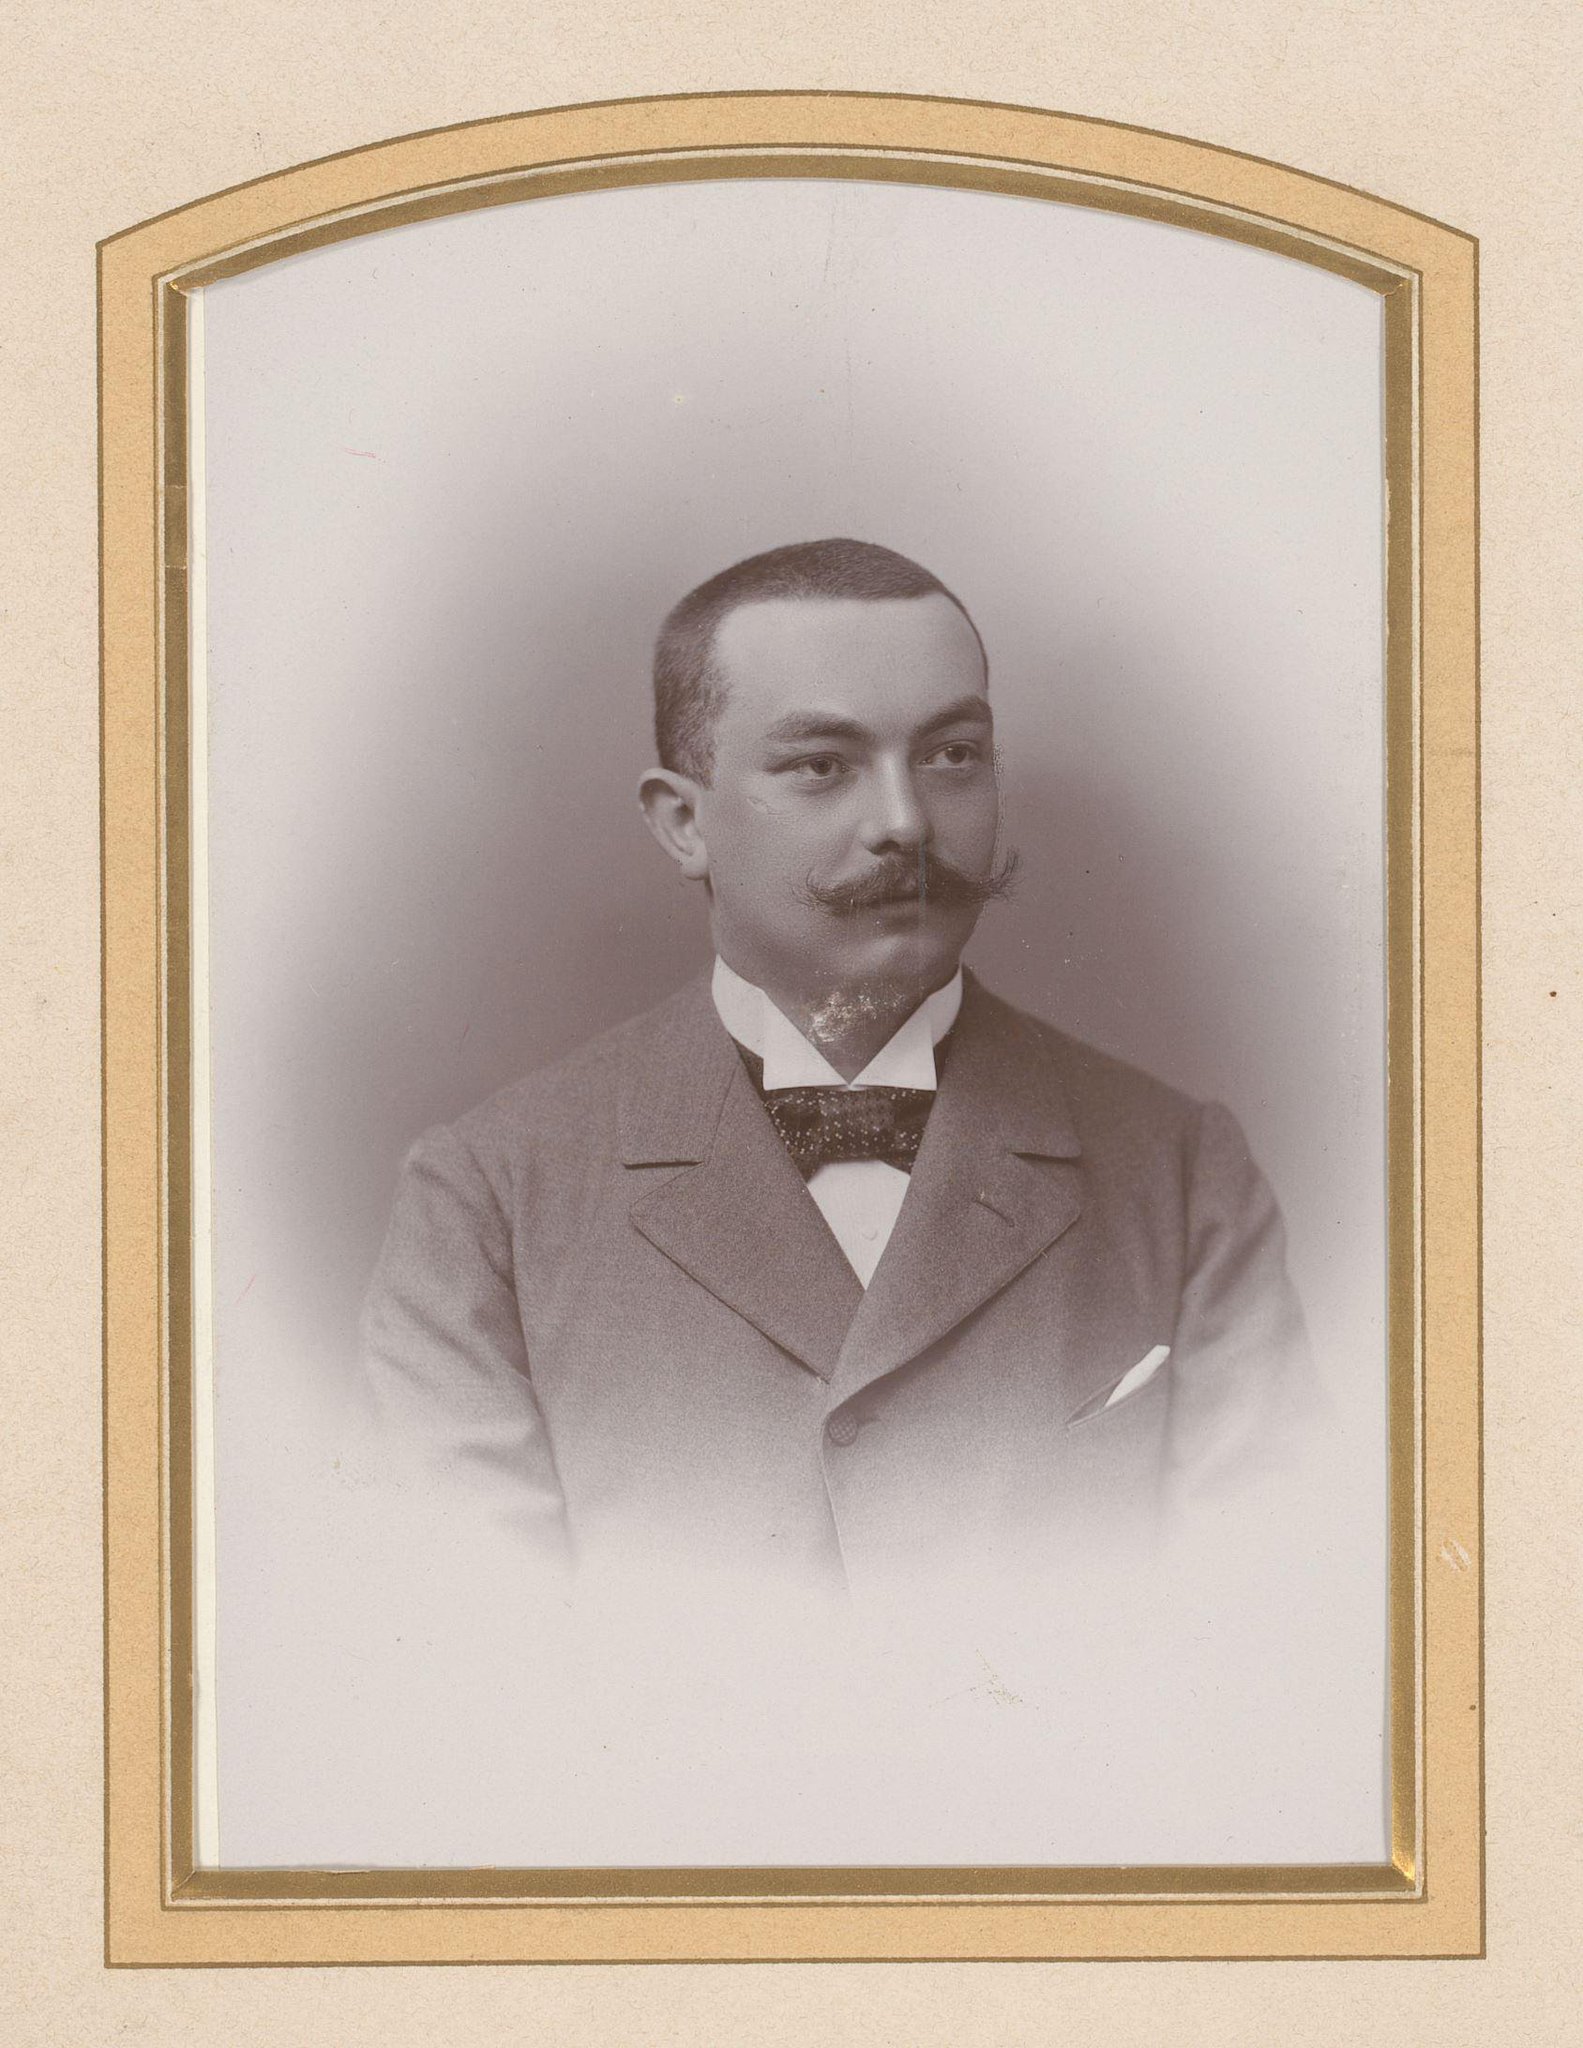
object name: album leaf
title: Portret van een man met snor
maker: georges michel (fotograaf)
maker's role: fotograaf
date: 1870-1900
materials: cardboard, photographic support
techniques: collodion silver print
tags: moustache, adult man, historical persons